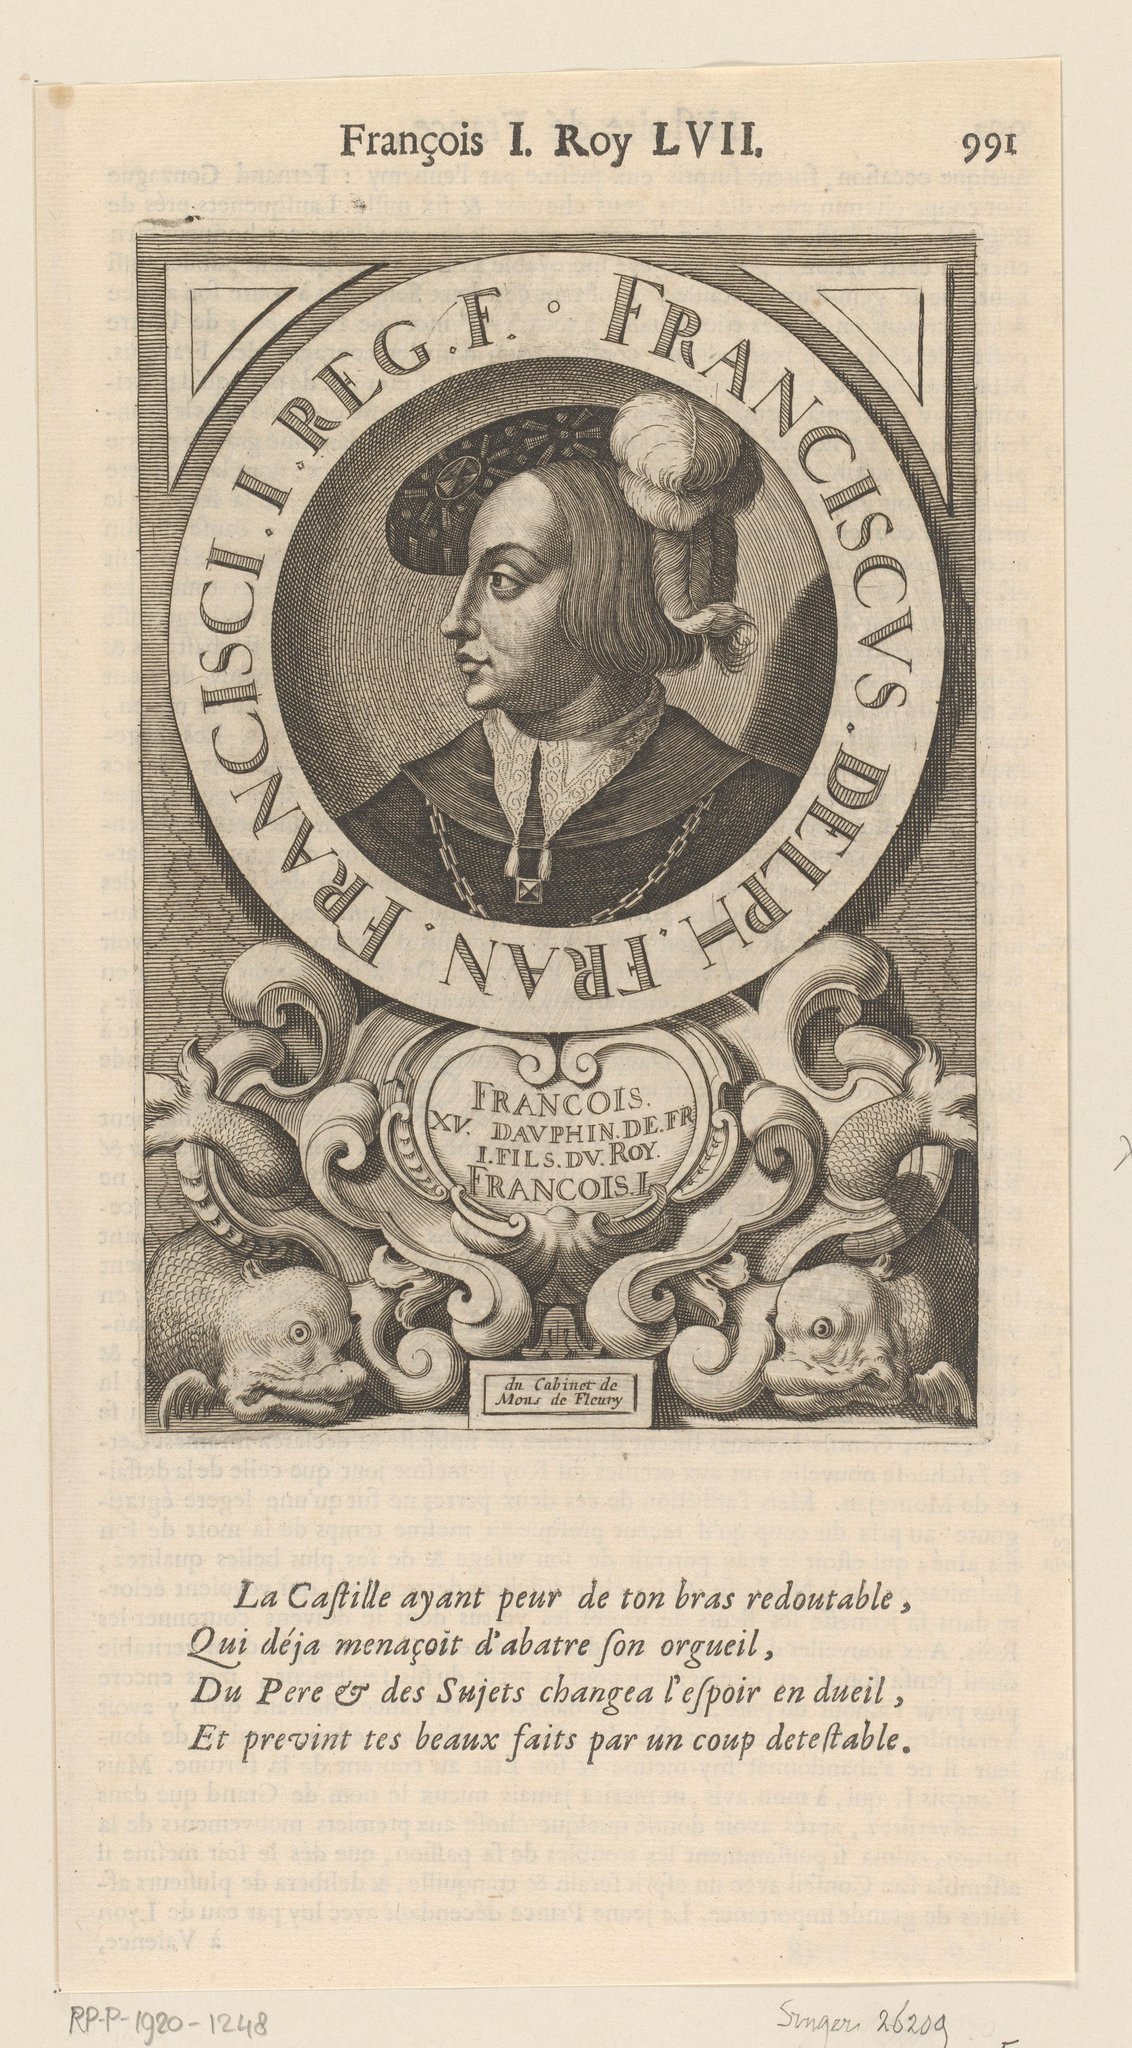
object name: book illustration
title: Francois XV dauphin de Fr. I fils du roy Francois I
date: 1635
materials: paper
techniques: engraving, letterpress printing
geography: paris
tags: historical persons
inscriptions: collector's mark: Lugt 2228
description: Prent uit: Eudes de Mézeray, François. Histoire de France, depuis Faramond jusqu’au regne de Louis le Juste (...). 3 dln. Parijs: Denis Thierry, Jean Guignard en Claude Barbin, 1635, dl. 2. Prent waarschijnlijk voor het eerst verschenen in: Bie, Jacques de. Les vrais portraits des rois de France (...). Parijs: Jacques de Bie en Pierre Rocolet, 1634. Prent ook gebruikt in latere publicaties.